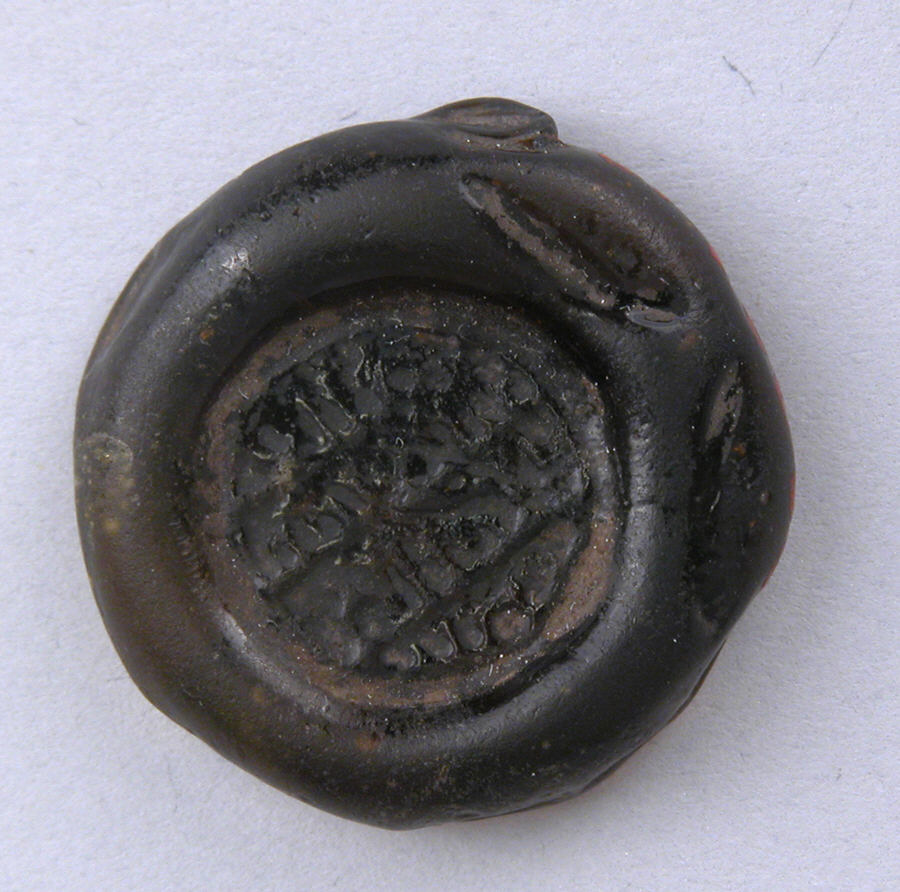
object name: coin weight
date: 1201-1400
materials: glass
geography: egypt